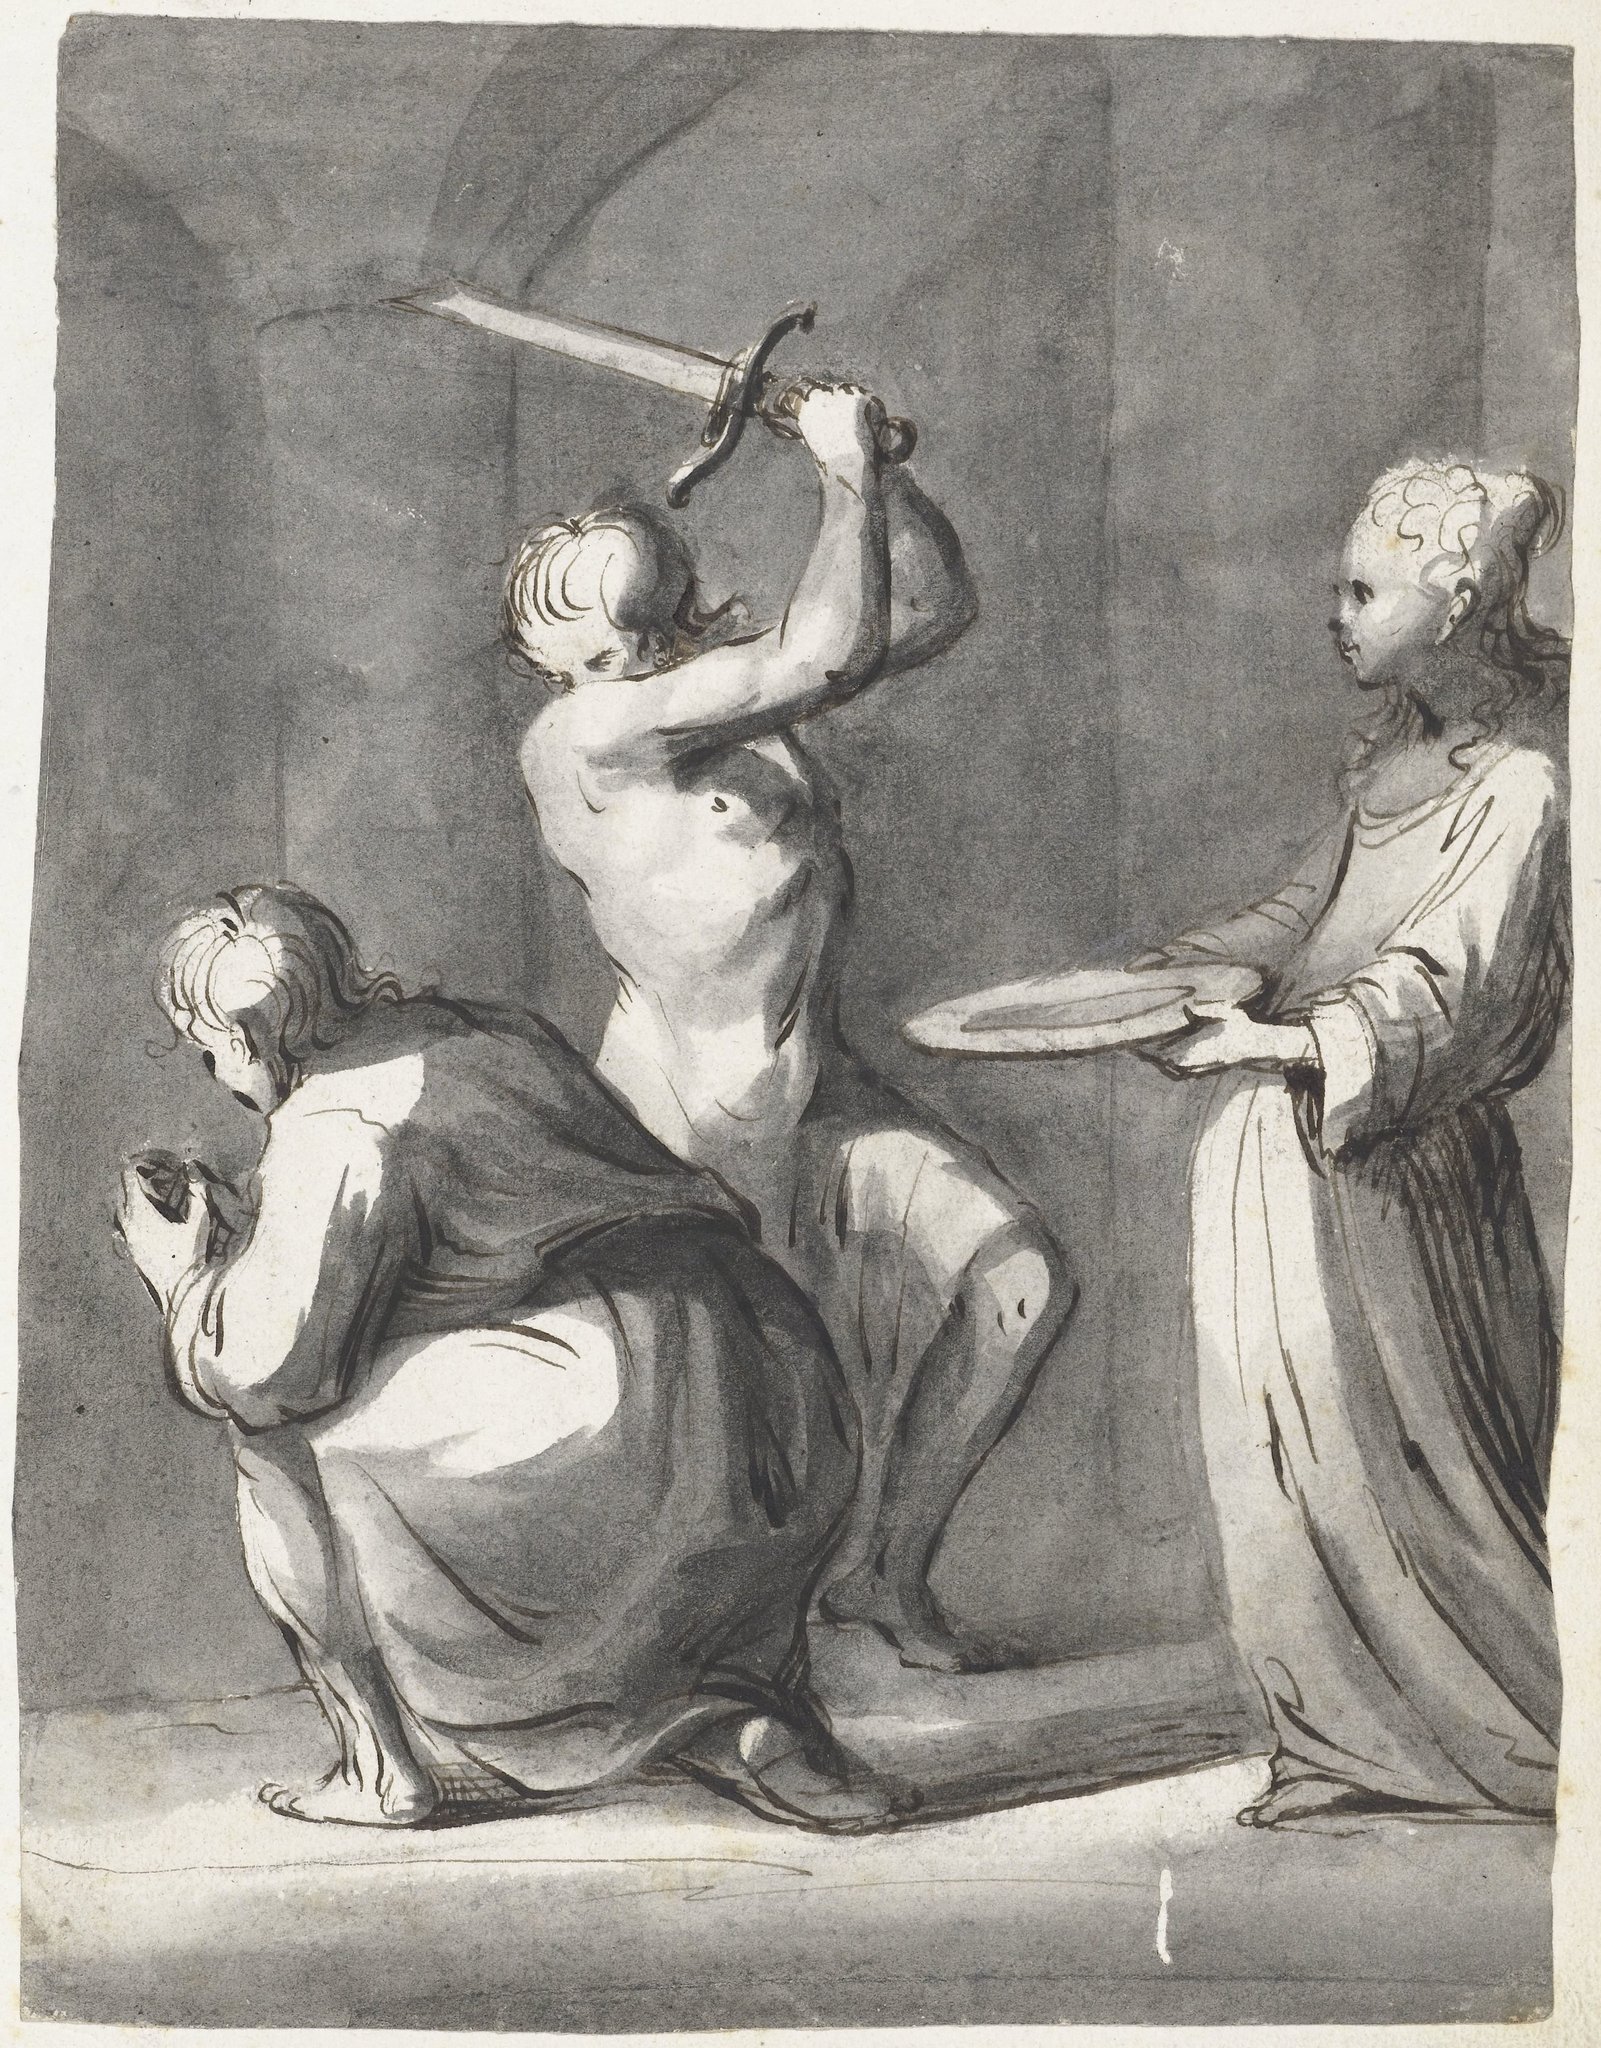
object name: drawing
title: Onthoofding van Johannes de Doper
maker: moses ter borch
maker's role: draughtsman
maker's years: 1645-1667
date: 1661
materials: chalk, ink, paper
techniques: brush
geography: zwolle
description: Een van twee bladen op hetzelfde blad geplakt in het Plakboek.